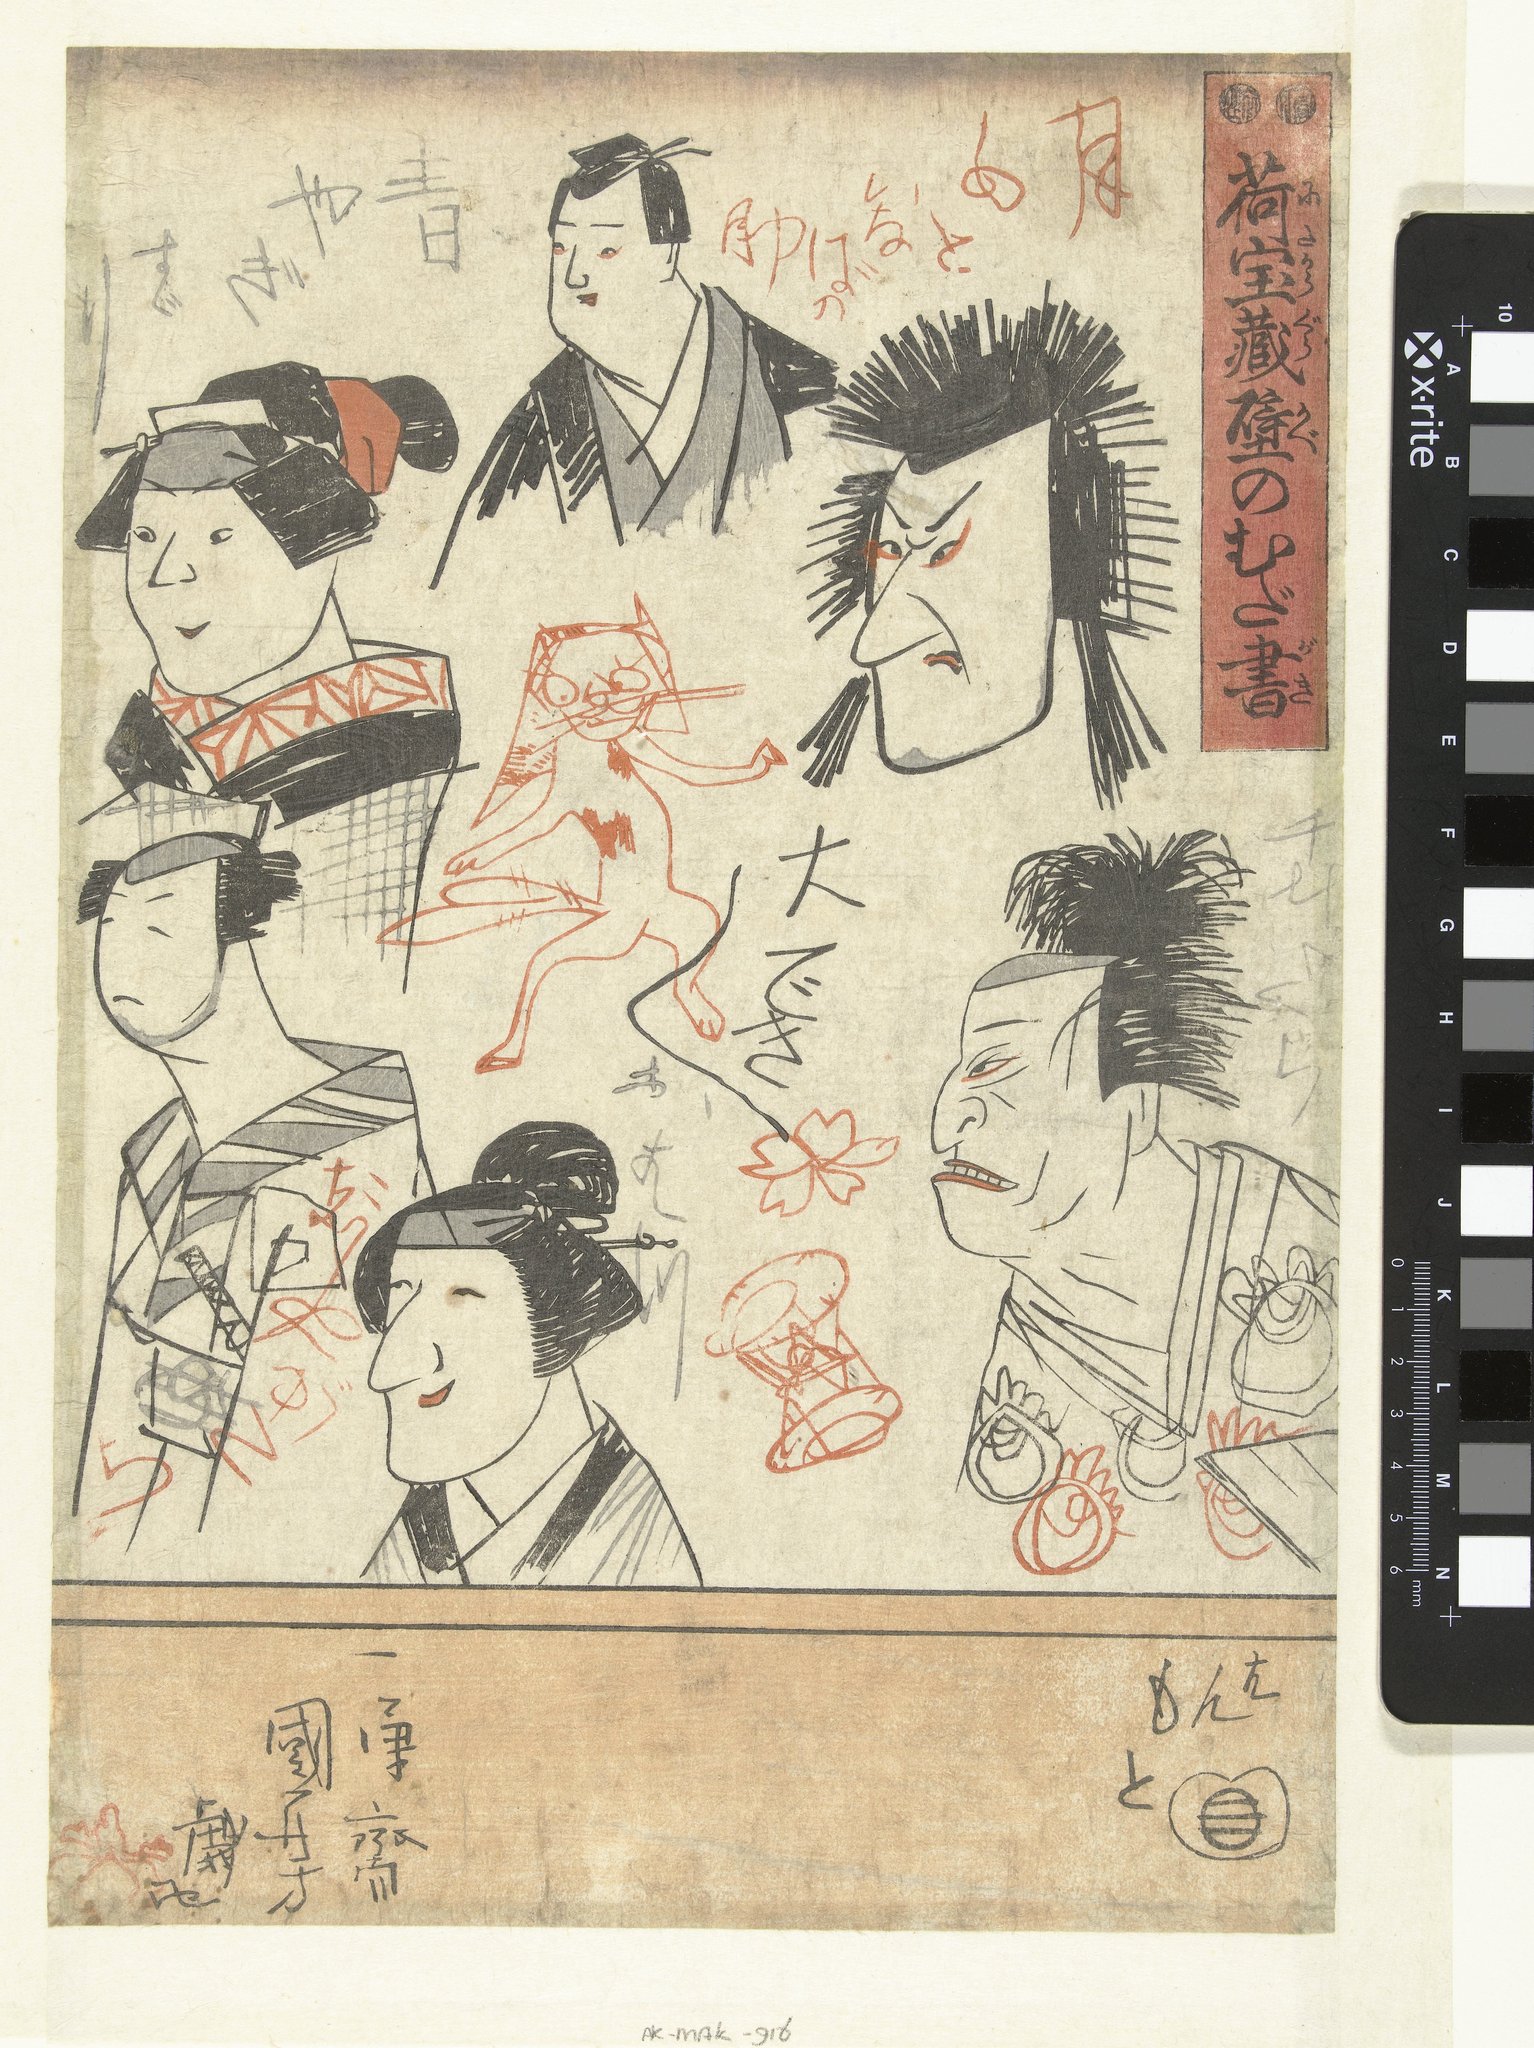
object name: print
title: Nitakaragura kabe no mudagaki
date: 1847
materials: paper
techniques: woodcut, nishiki e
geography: japan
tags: head (human), cat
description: Wand waarop graffiti voorstellende zes acteursportretten, een kat en een handtrommel.